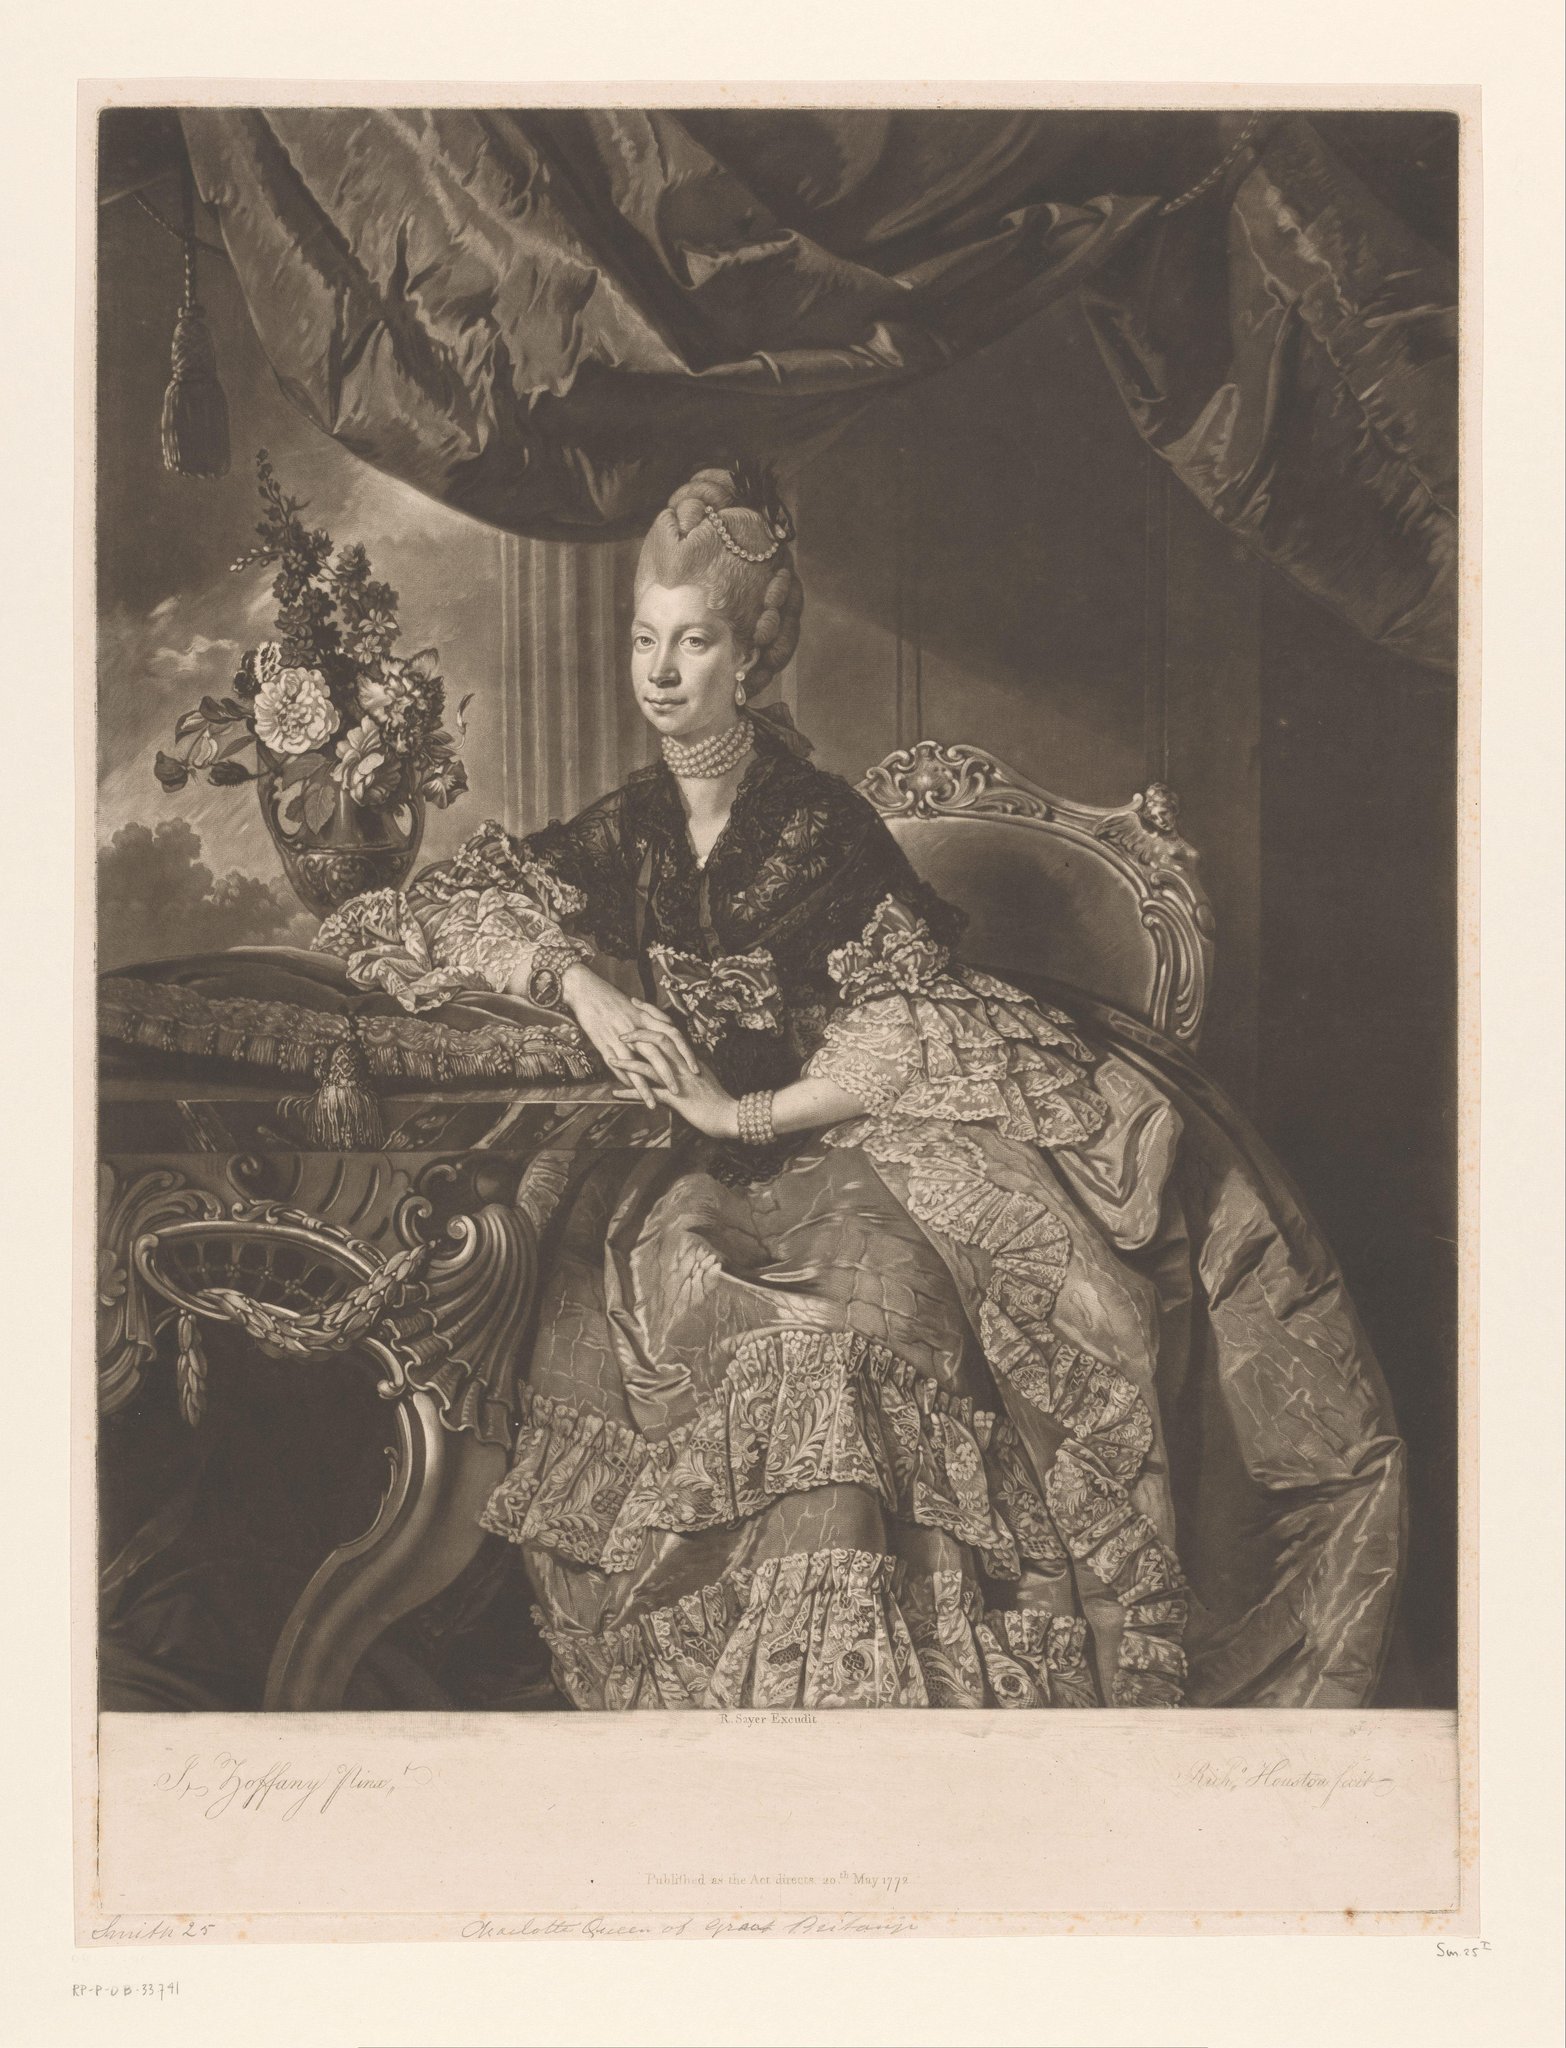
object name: print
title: Portret van Charlotte van Mecklenburg-Strelitz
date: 1772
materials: paper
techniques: mezzotint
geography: london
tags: charlotte van mecklenburg-strelitz (koningin van engeland en ierland), historical persons, queen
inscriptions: collector's mark: Lugt 240